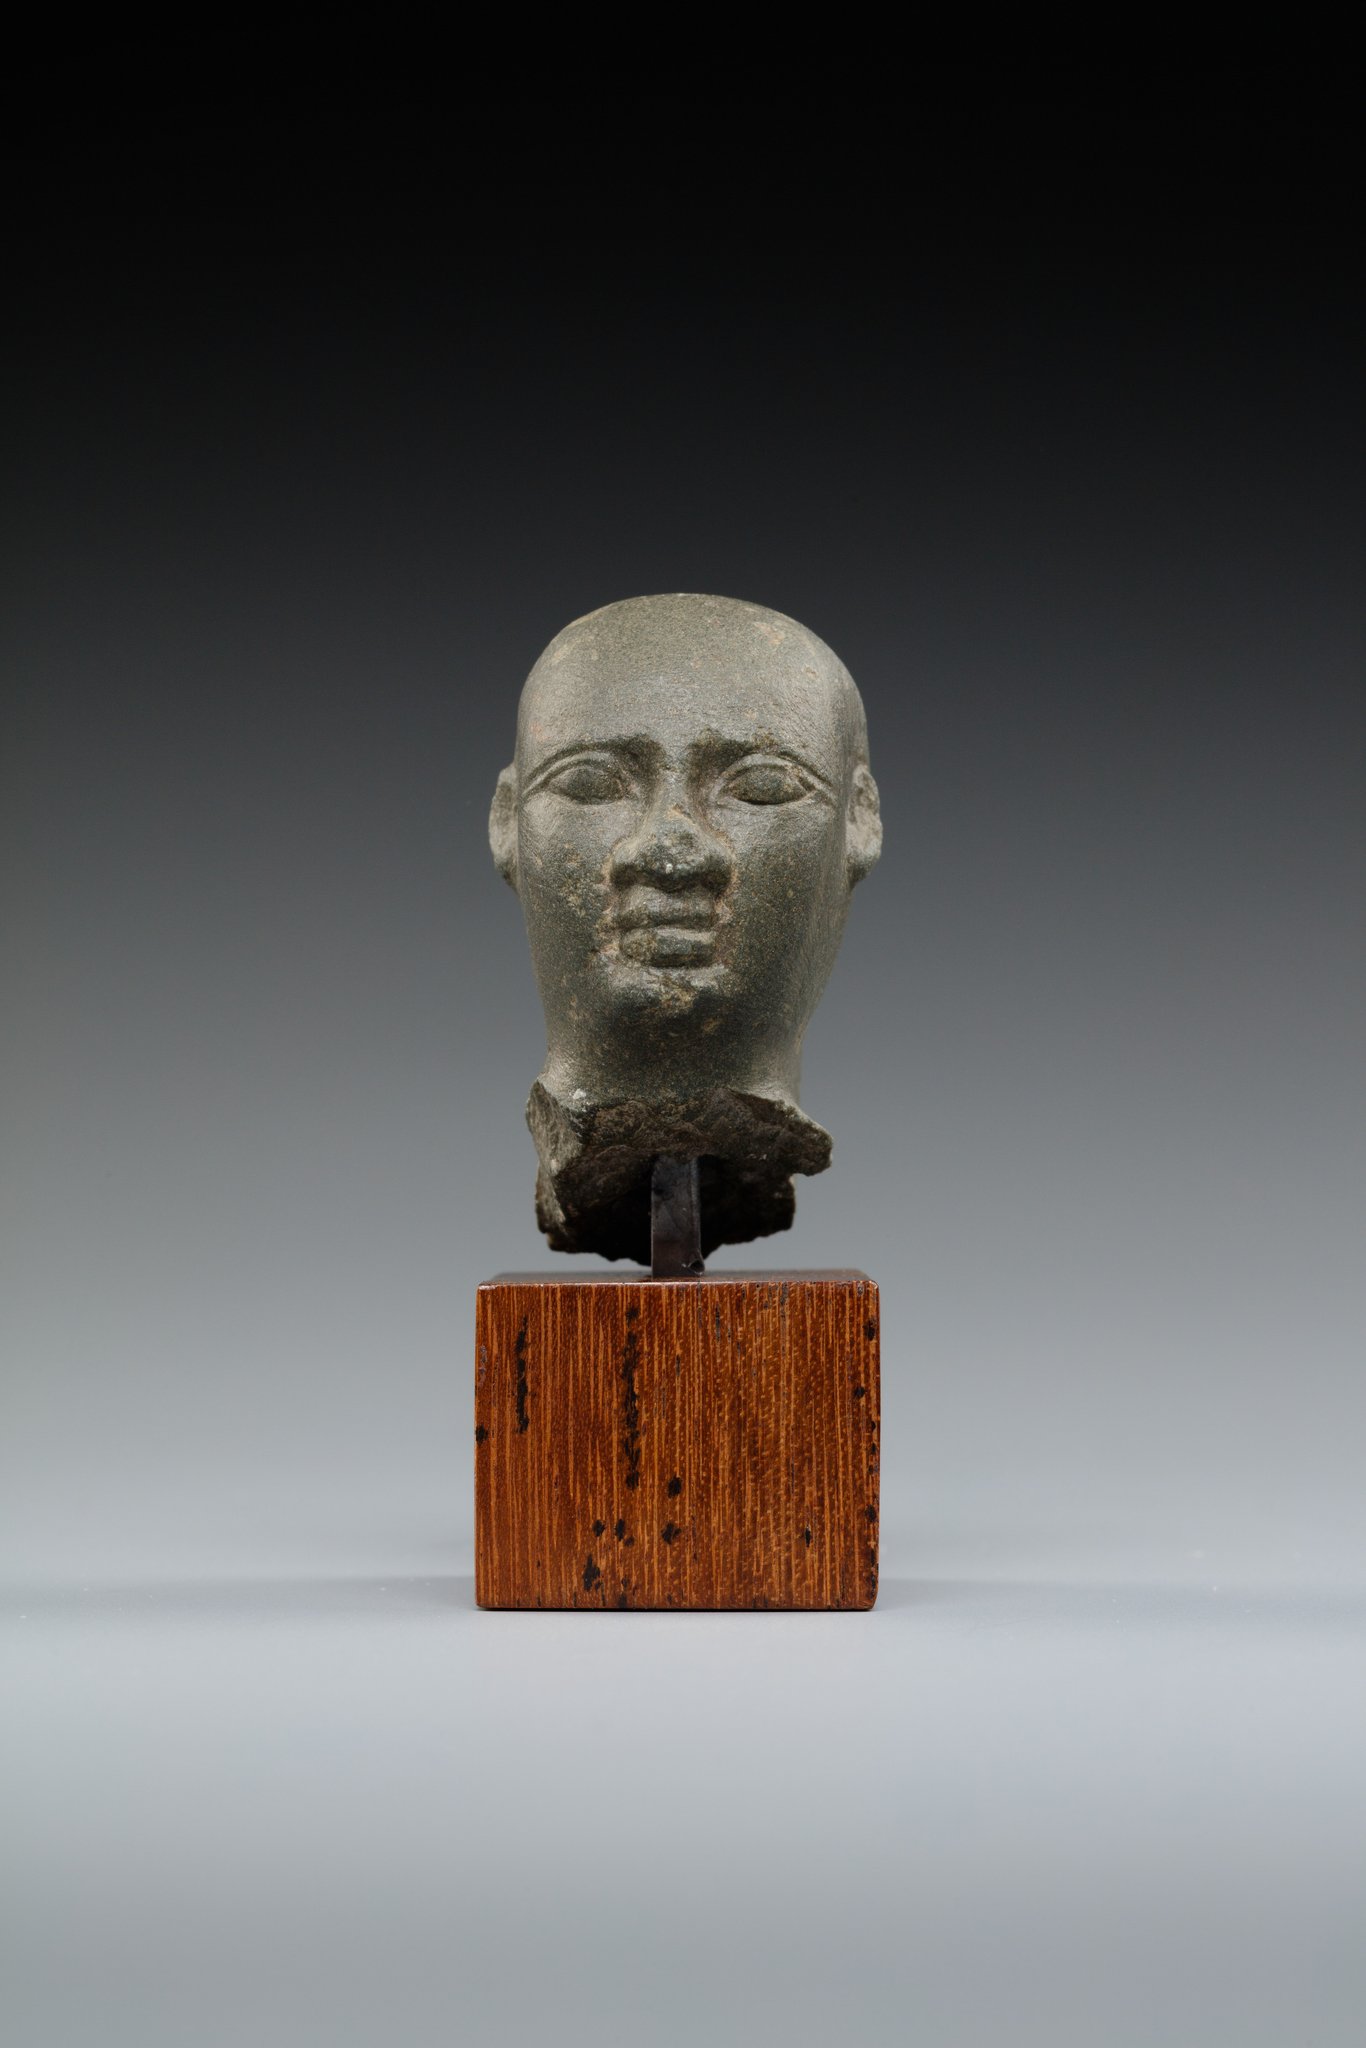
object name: head from the figure of an official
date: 1800-1650 BCE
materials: stone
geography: egypt